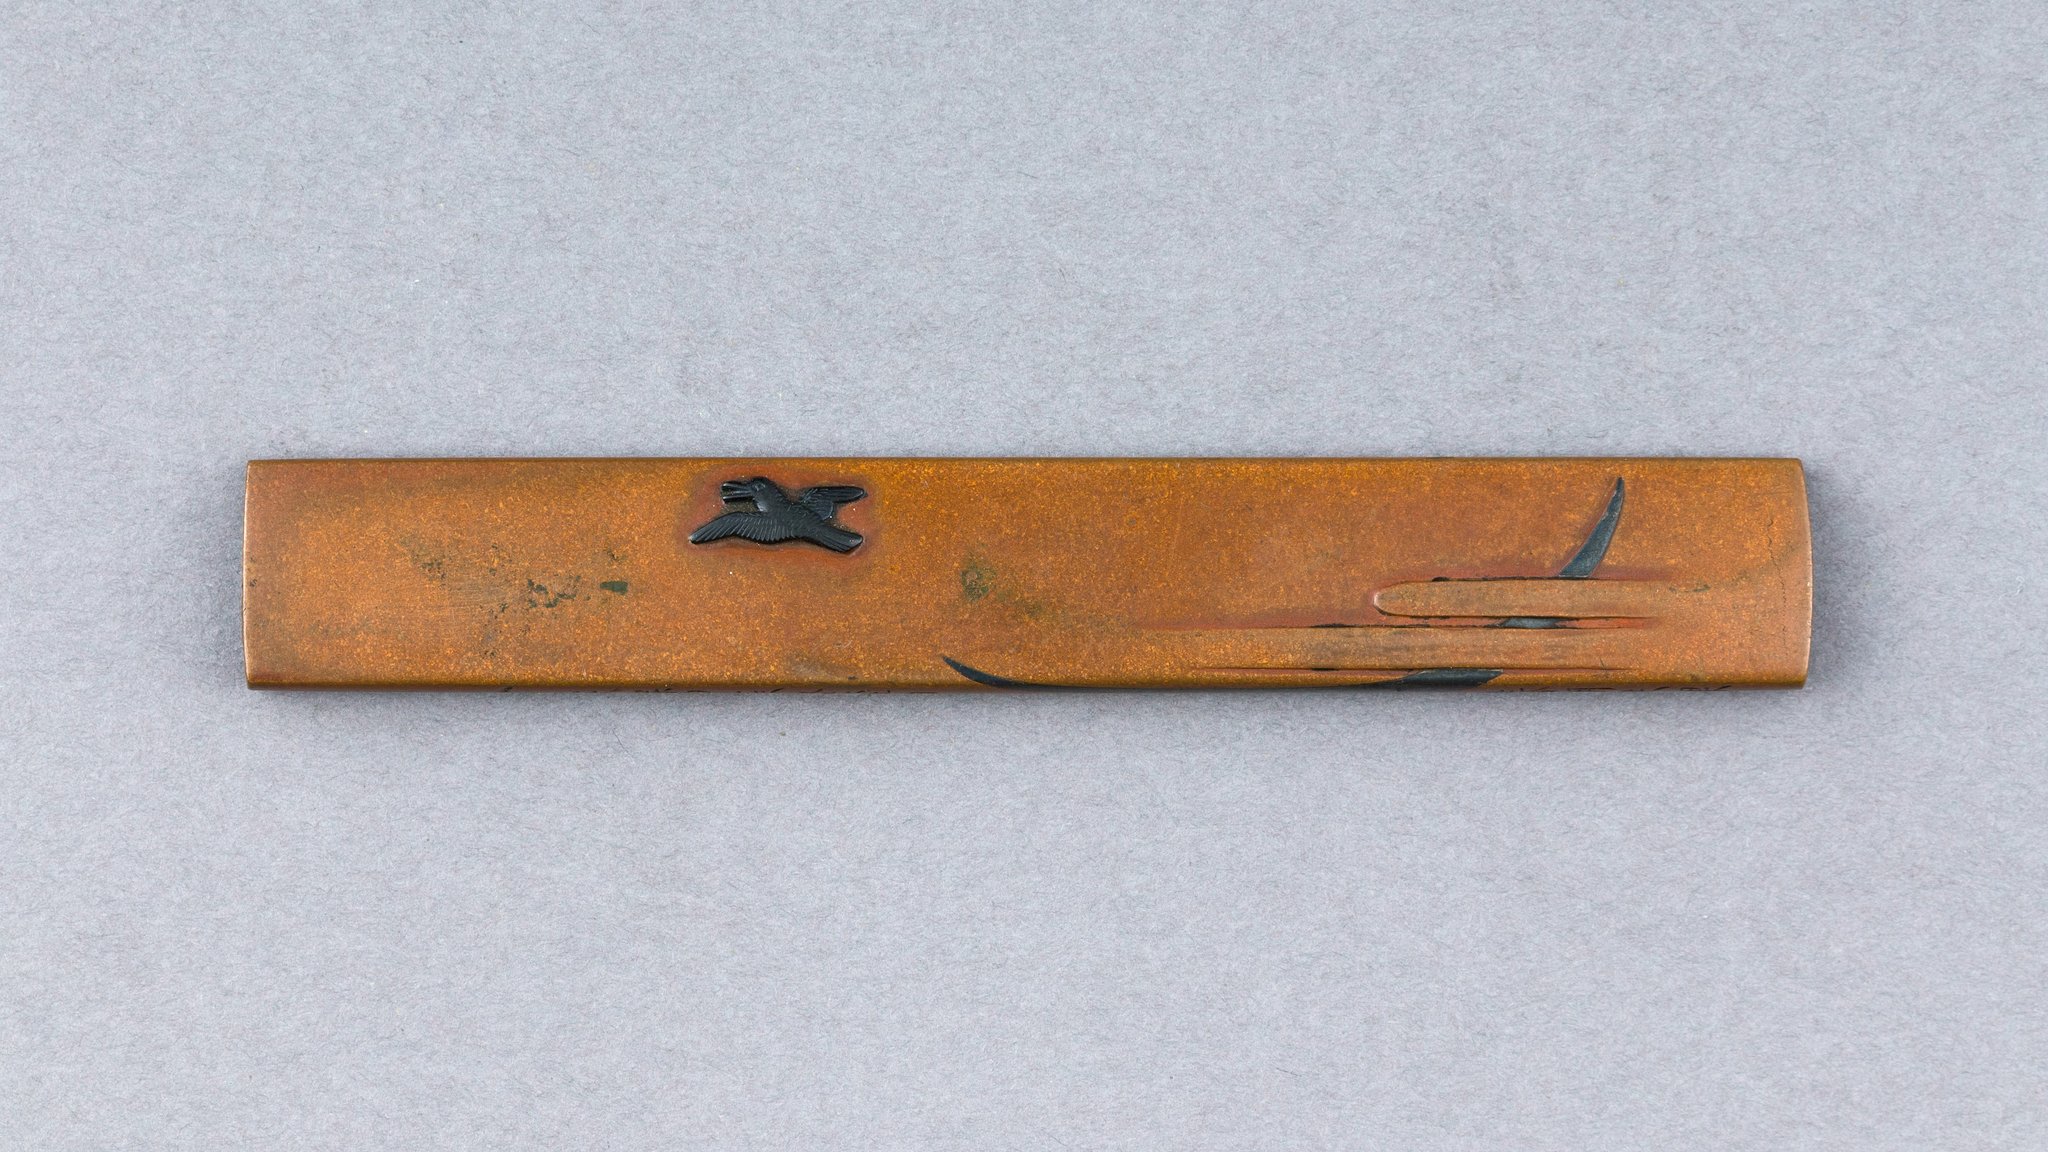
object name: knife handle kozuka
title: Knife Handle (Kozuka)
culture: japanese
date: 1615-1868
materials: copper, gold alloy, silver alloy, gold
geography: japan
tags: birds